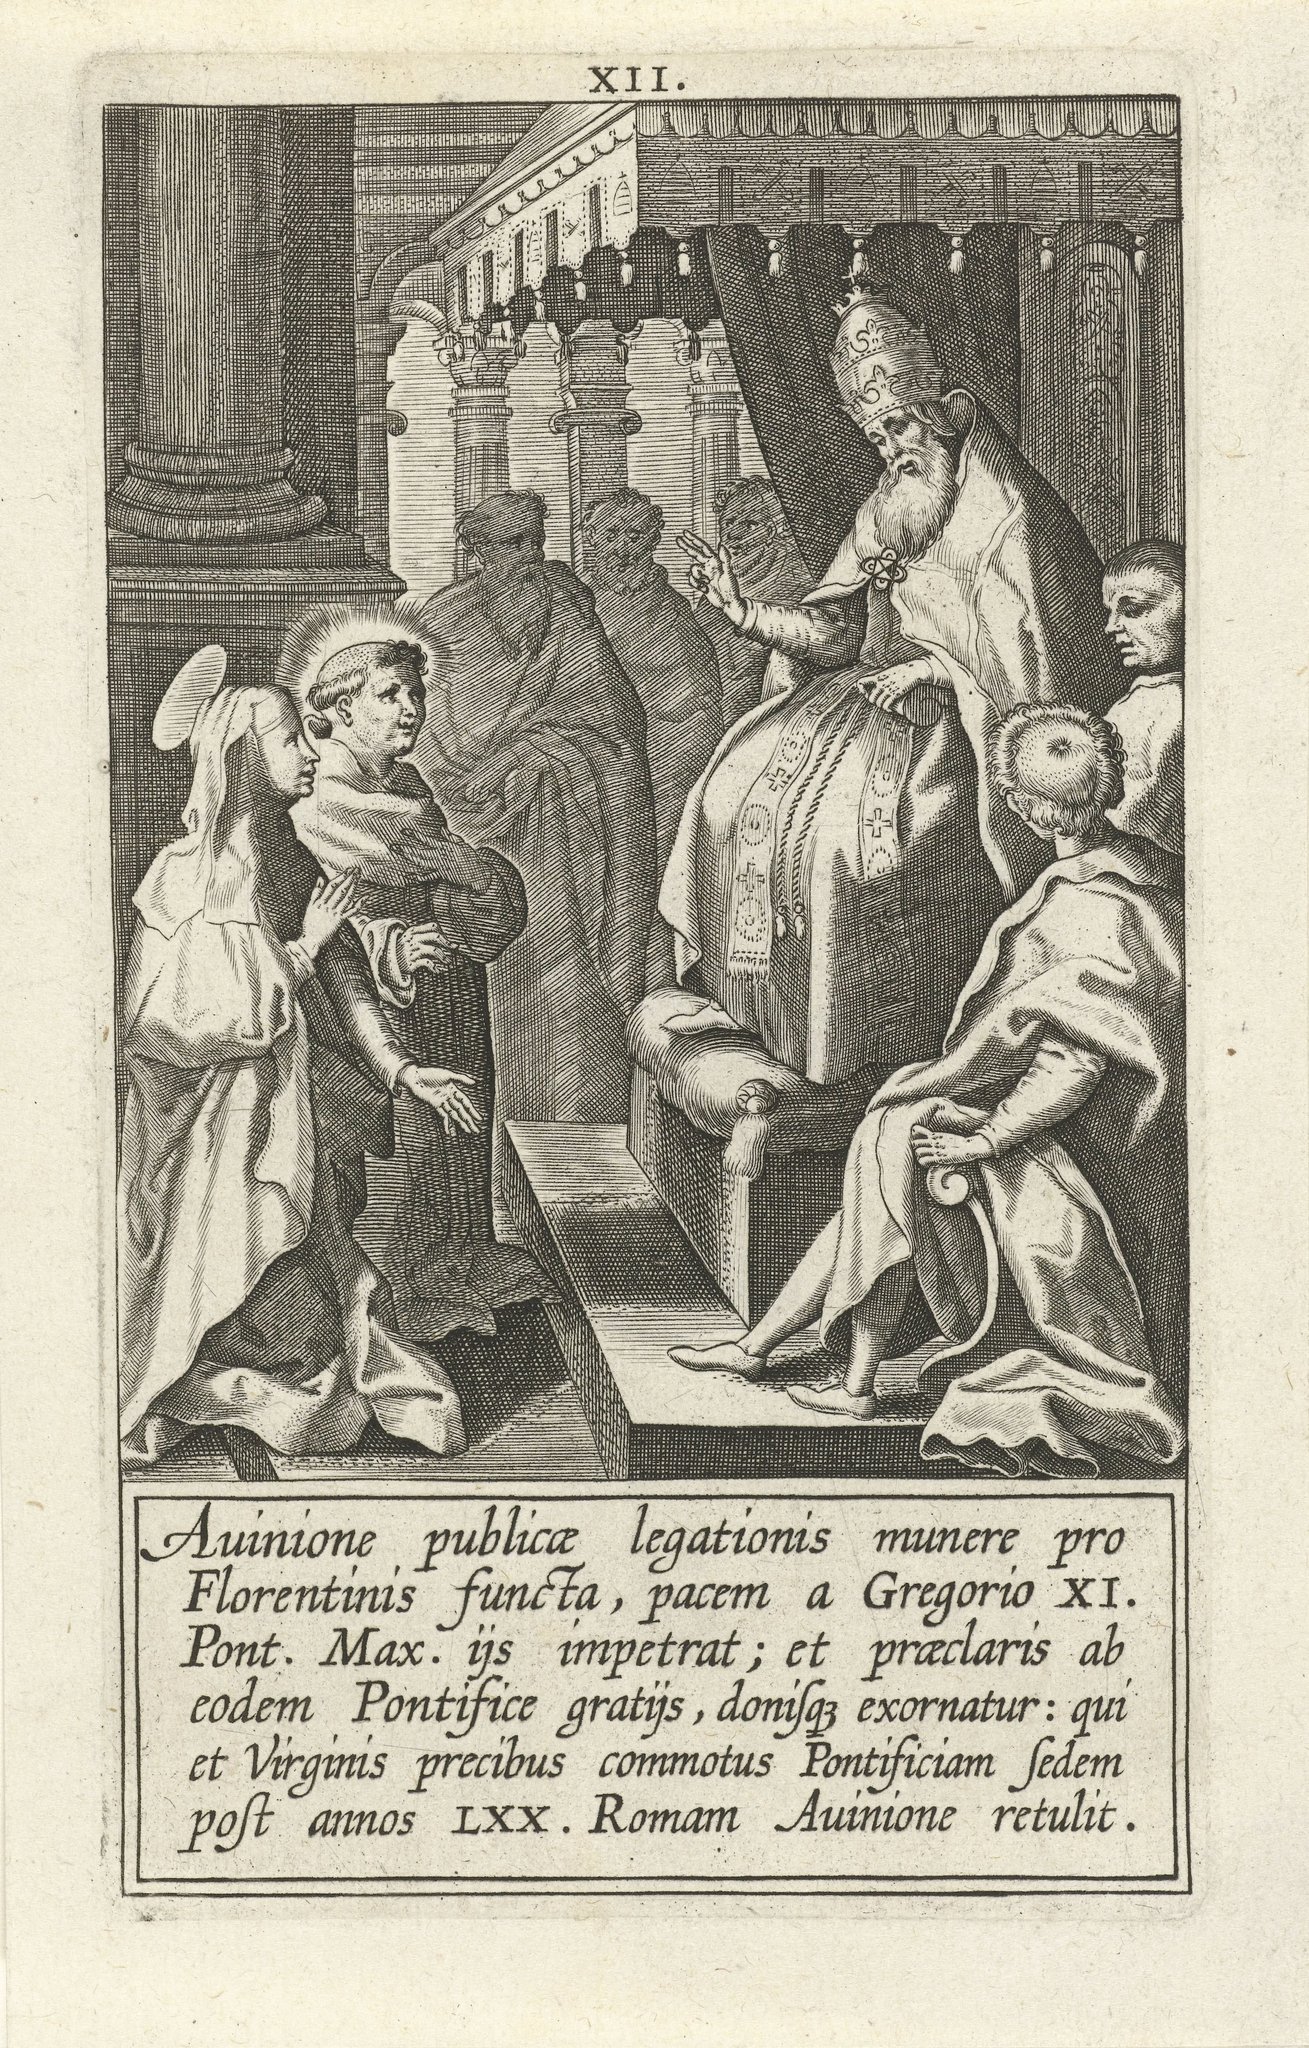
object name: print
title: Het leven van de H. Catharina van Siena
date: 1603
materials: paper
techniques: engraving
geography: antwerp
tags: rome, pope gregory xi returns from avignon to rome after a visit from st. catherine of siena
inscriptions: collector's mark: Lugt 2228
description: Catharina en een mannelijke dominicaan aan het hof van de paus in Avignon. Ze halen paus Gregorius XI over om terug te keren naar Italië. Deel van een serie over Catharina van Siena bestaande uit een titelprent, een portret en 32 genummerde scènes uit haar leven.